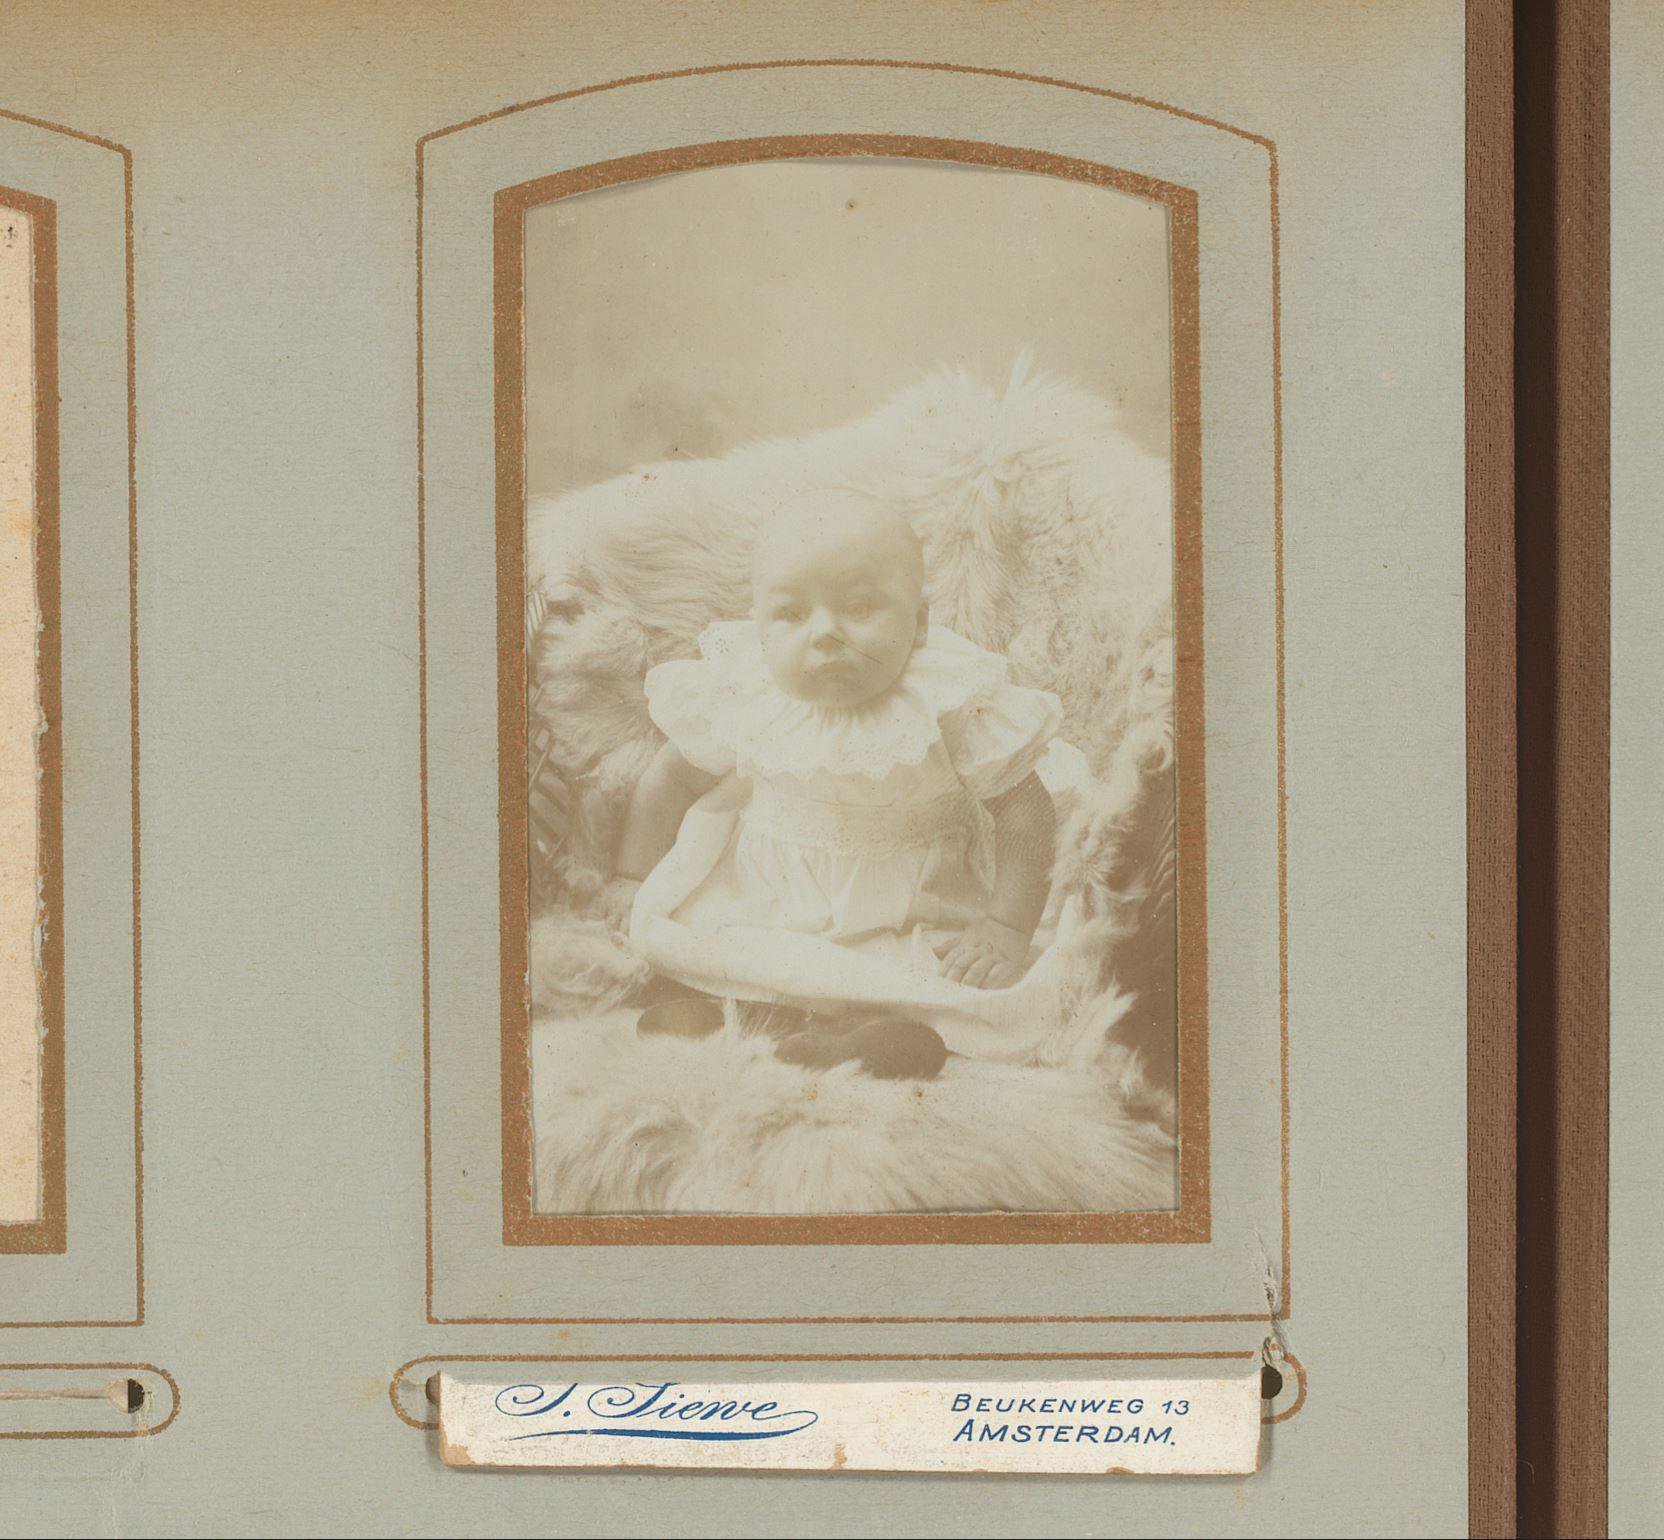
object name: carte de visite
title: Portret van een kind, zittend op een stoel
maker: j. siewe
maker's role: fotograaf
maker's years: 1873-1905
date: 1891-1898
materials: cardboard, photographic support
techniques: collodion silver print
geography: amsterdam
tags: child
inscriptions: inscription: ‘J. Siewe/ Amsterdam’